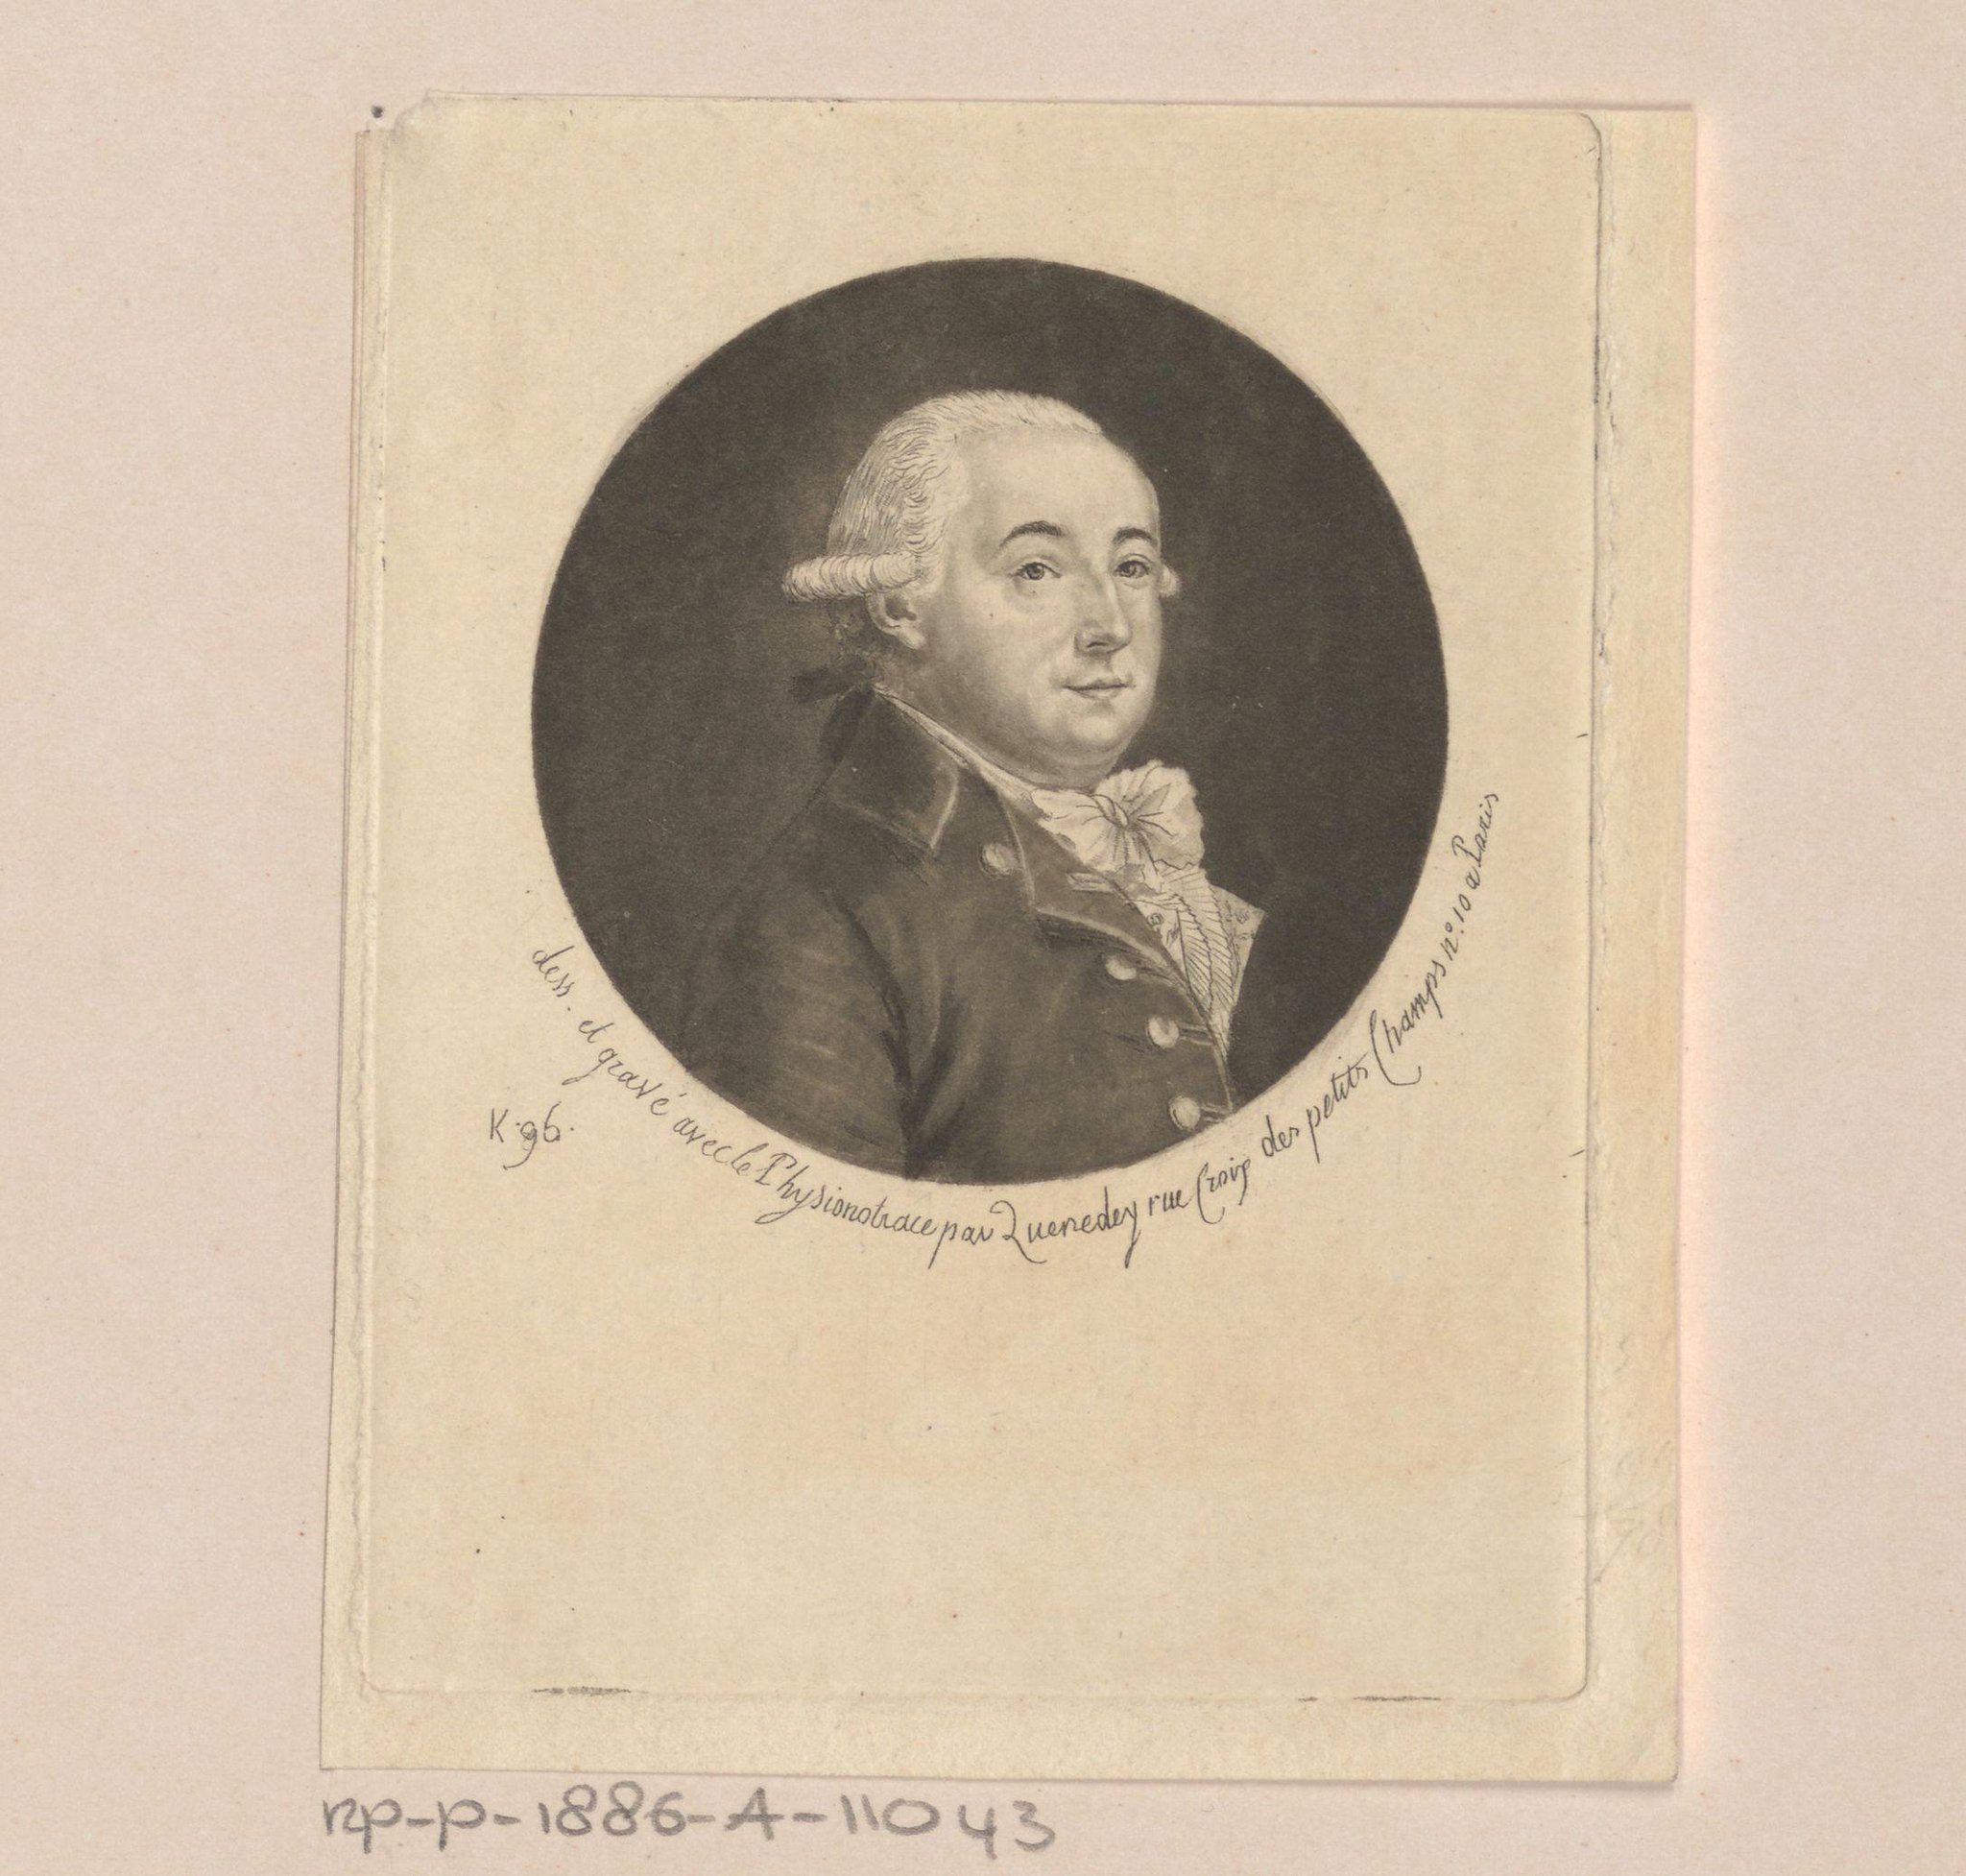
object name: physionotrace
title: Portret van Jacob van Staphorst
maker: edme quenedey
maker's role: print maker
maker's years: 1756-1830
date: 1785-1830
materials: paper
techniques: aquatint, etching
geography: paris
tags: politician, silhouette-apparatus, 'physionotrace', historical persons, politician, e.g. party leader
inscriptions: collector's mark: Lugt 2228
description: Met eenregelig onderschrift in het Frans. Linksonder portret: K 96.